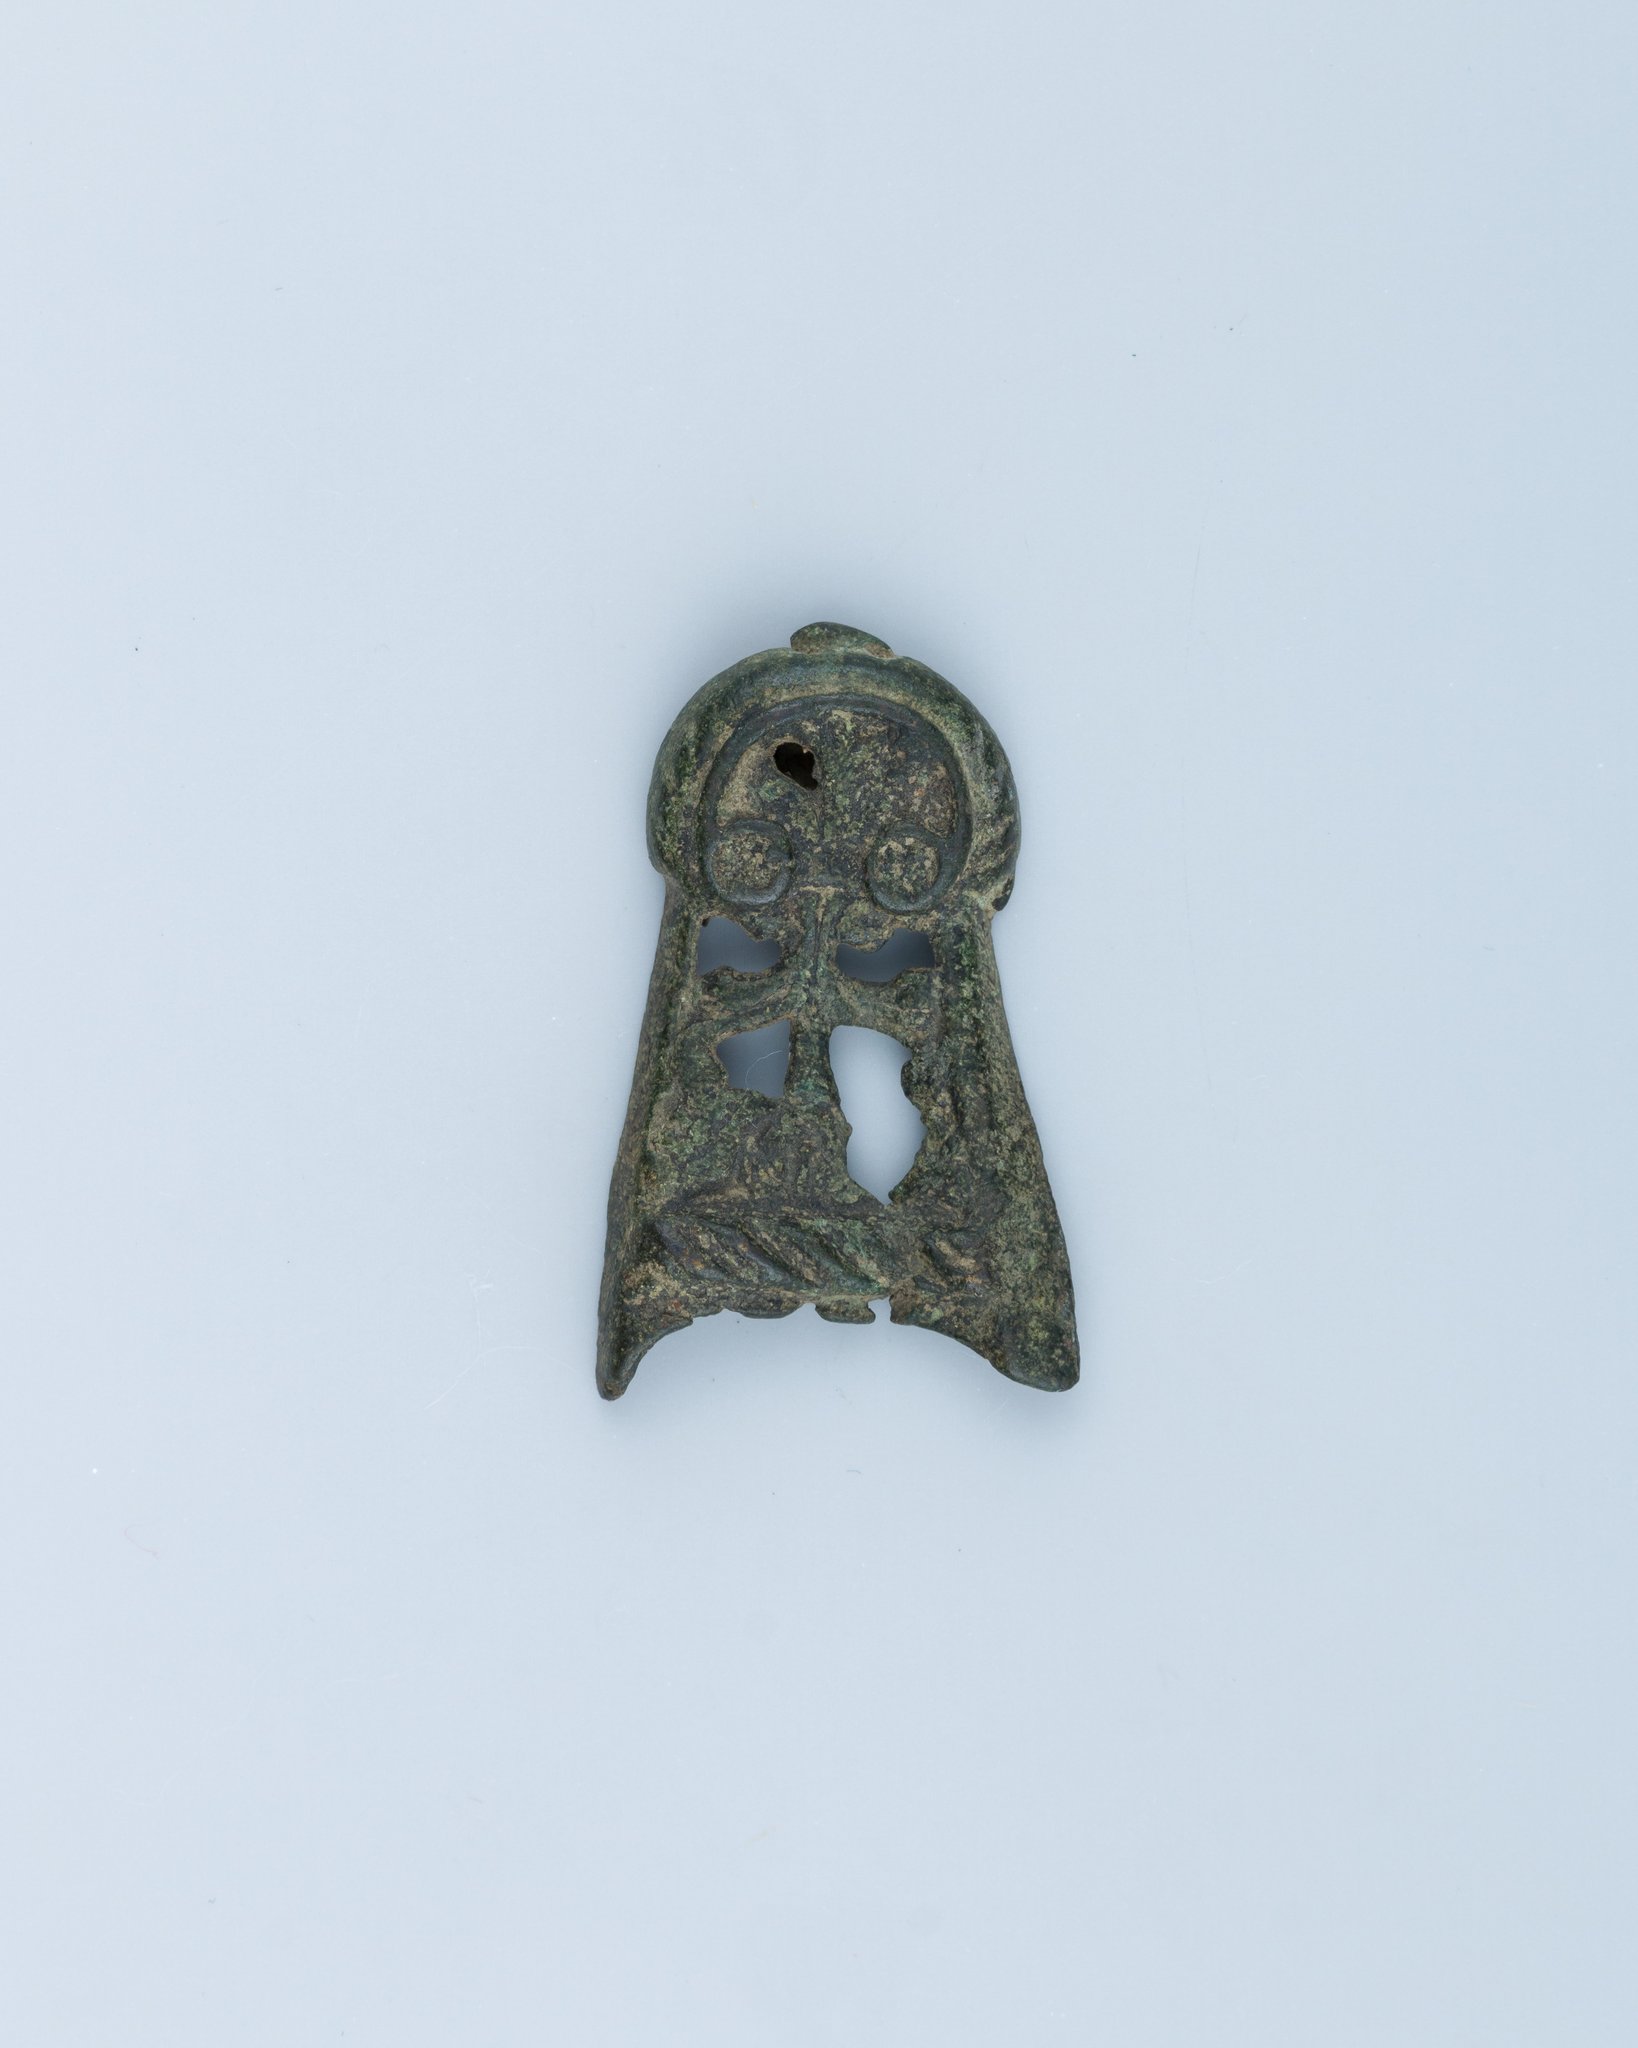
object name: pendant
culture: european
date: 1401-1700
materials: bronze